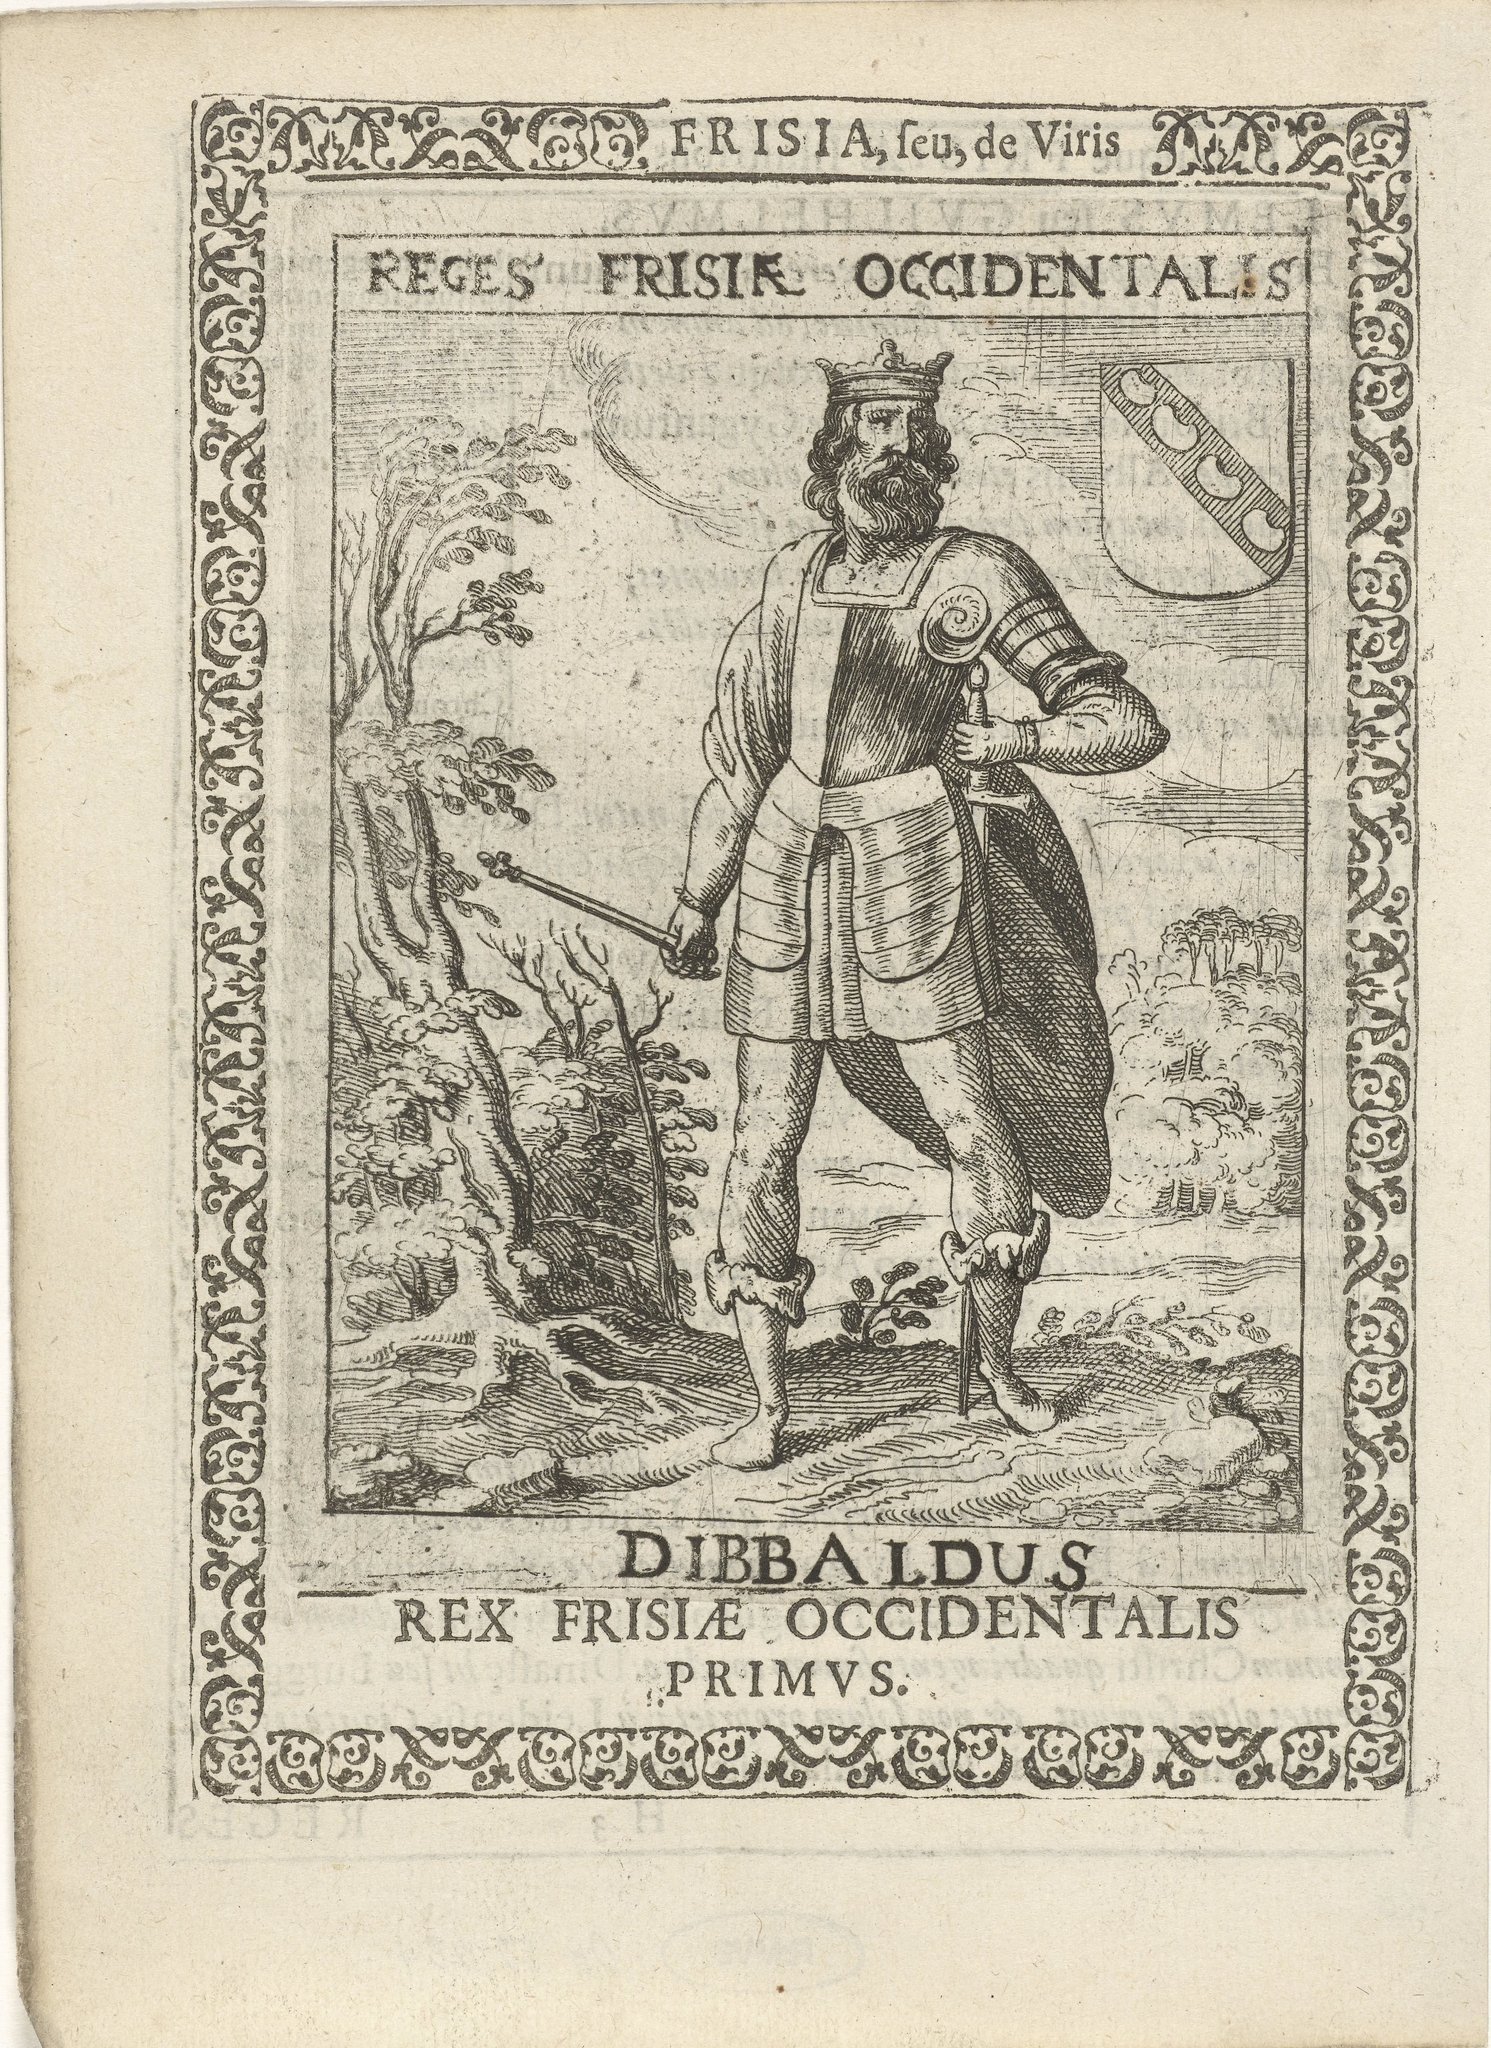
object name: print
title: Dibbaldus, eerste koning der West-Friezen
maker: pieter feddes van harlingen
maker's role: painter, print maker, publisher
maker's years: 1586-1623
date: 1618-1620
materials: paper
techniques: etching, letterpress printing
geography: friesland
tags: ruler, sovereign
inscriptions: collector's mark: Lugt 2228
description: Dibbaldus, eerste koning der West-Friezen. Staande ten voeten uit, scepter en zwaardgevest in de hand. In een ornamentale omlijsting. Illustratie, met tekst op achterzijde, afkomstig uit het boek: Frisia seu de viris rebusque Frisiae illustribus libri duo.